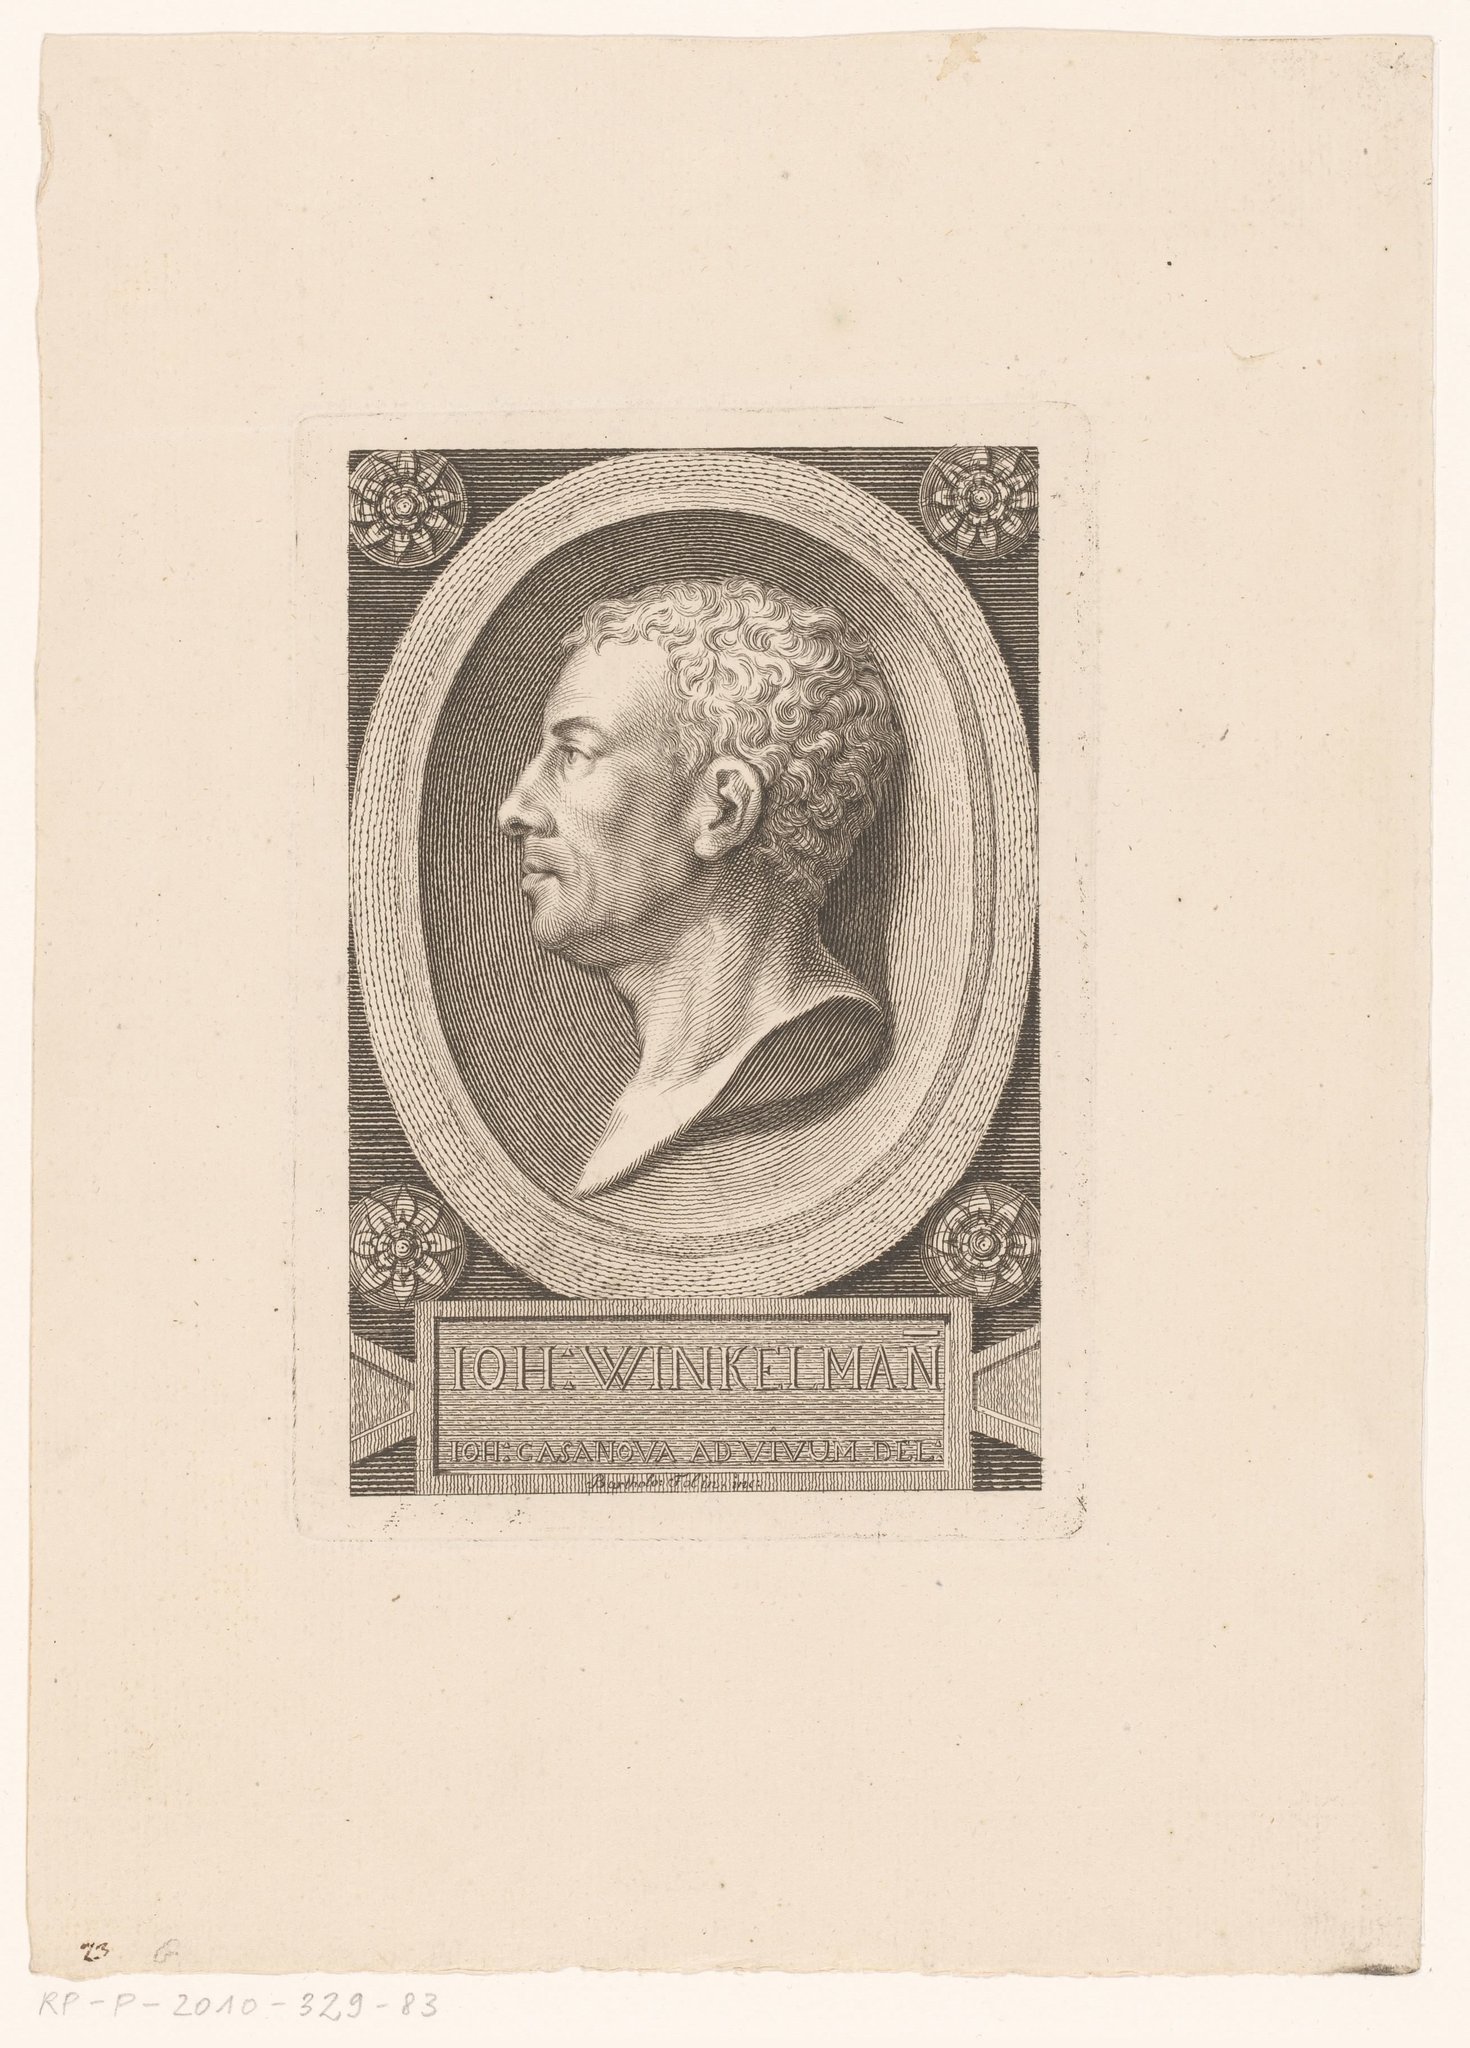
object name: print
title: Portretbuste van Johann Joachim Winckelmann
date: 1740-1808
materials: paper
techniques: engraving, etching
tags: scholar, philosopher, historical persons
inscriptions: number: ‘23’, collector's mark: Lugt 2228